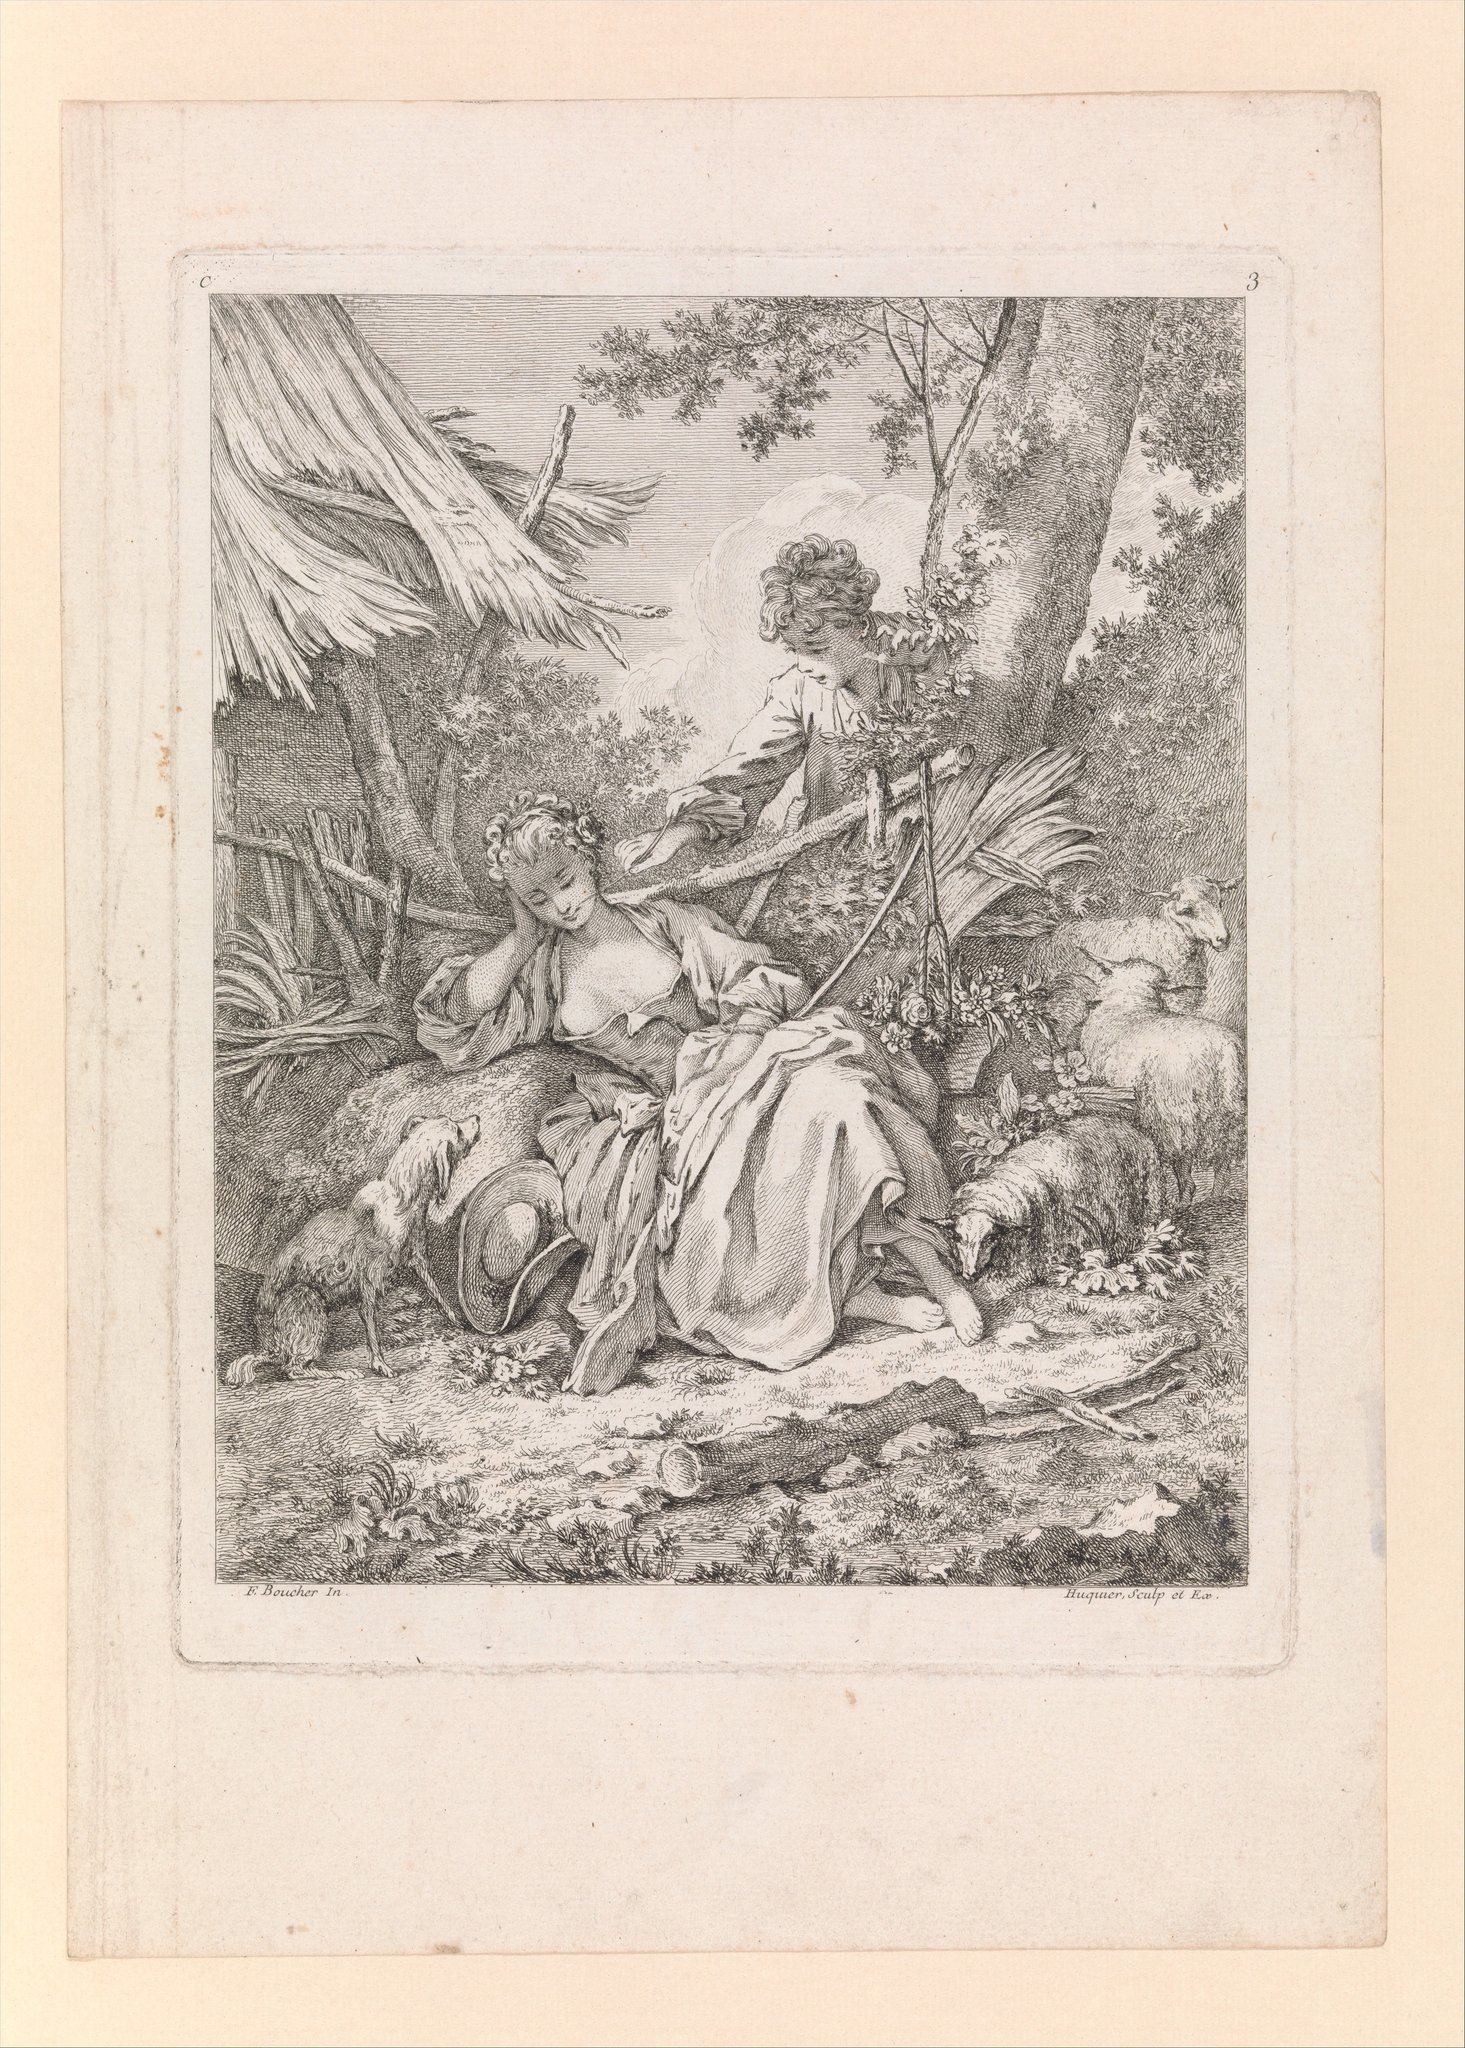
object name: print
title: Plate 3: Shepherd tickling a sleeping Shepherdess with a piece of straw, from Troisieme Livre de Sujets et Pastorales (Third Book of Subjects and Pastorals)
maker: gabriel huquier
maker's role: artist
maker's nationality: french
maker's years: 1695-1772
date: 1720-1772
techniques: engraving, etching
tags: animals,men,women,shepherds